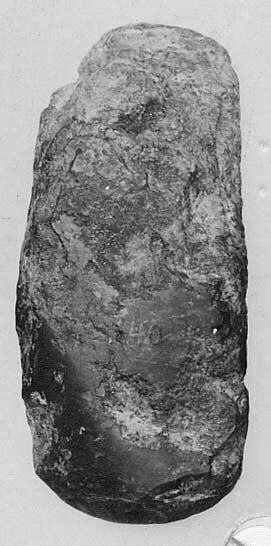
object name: axe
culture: north american, alaskan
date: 1902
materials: jade